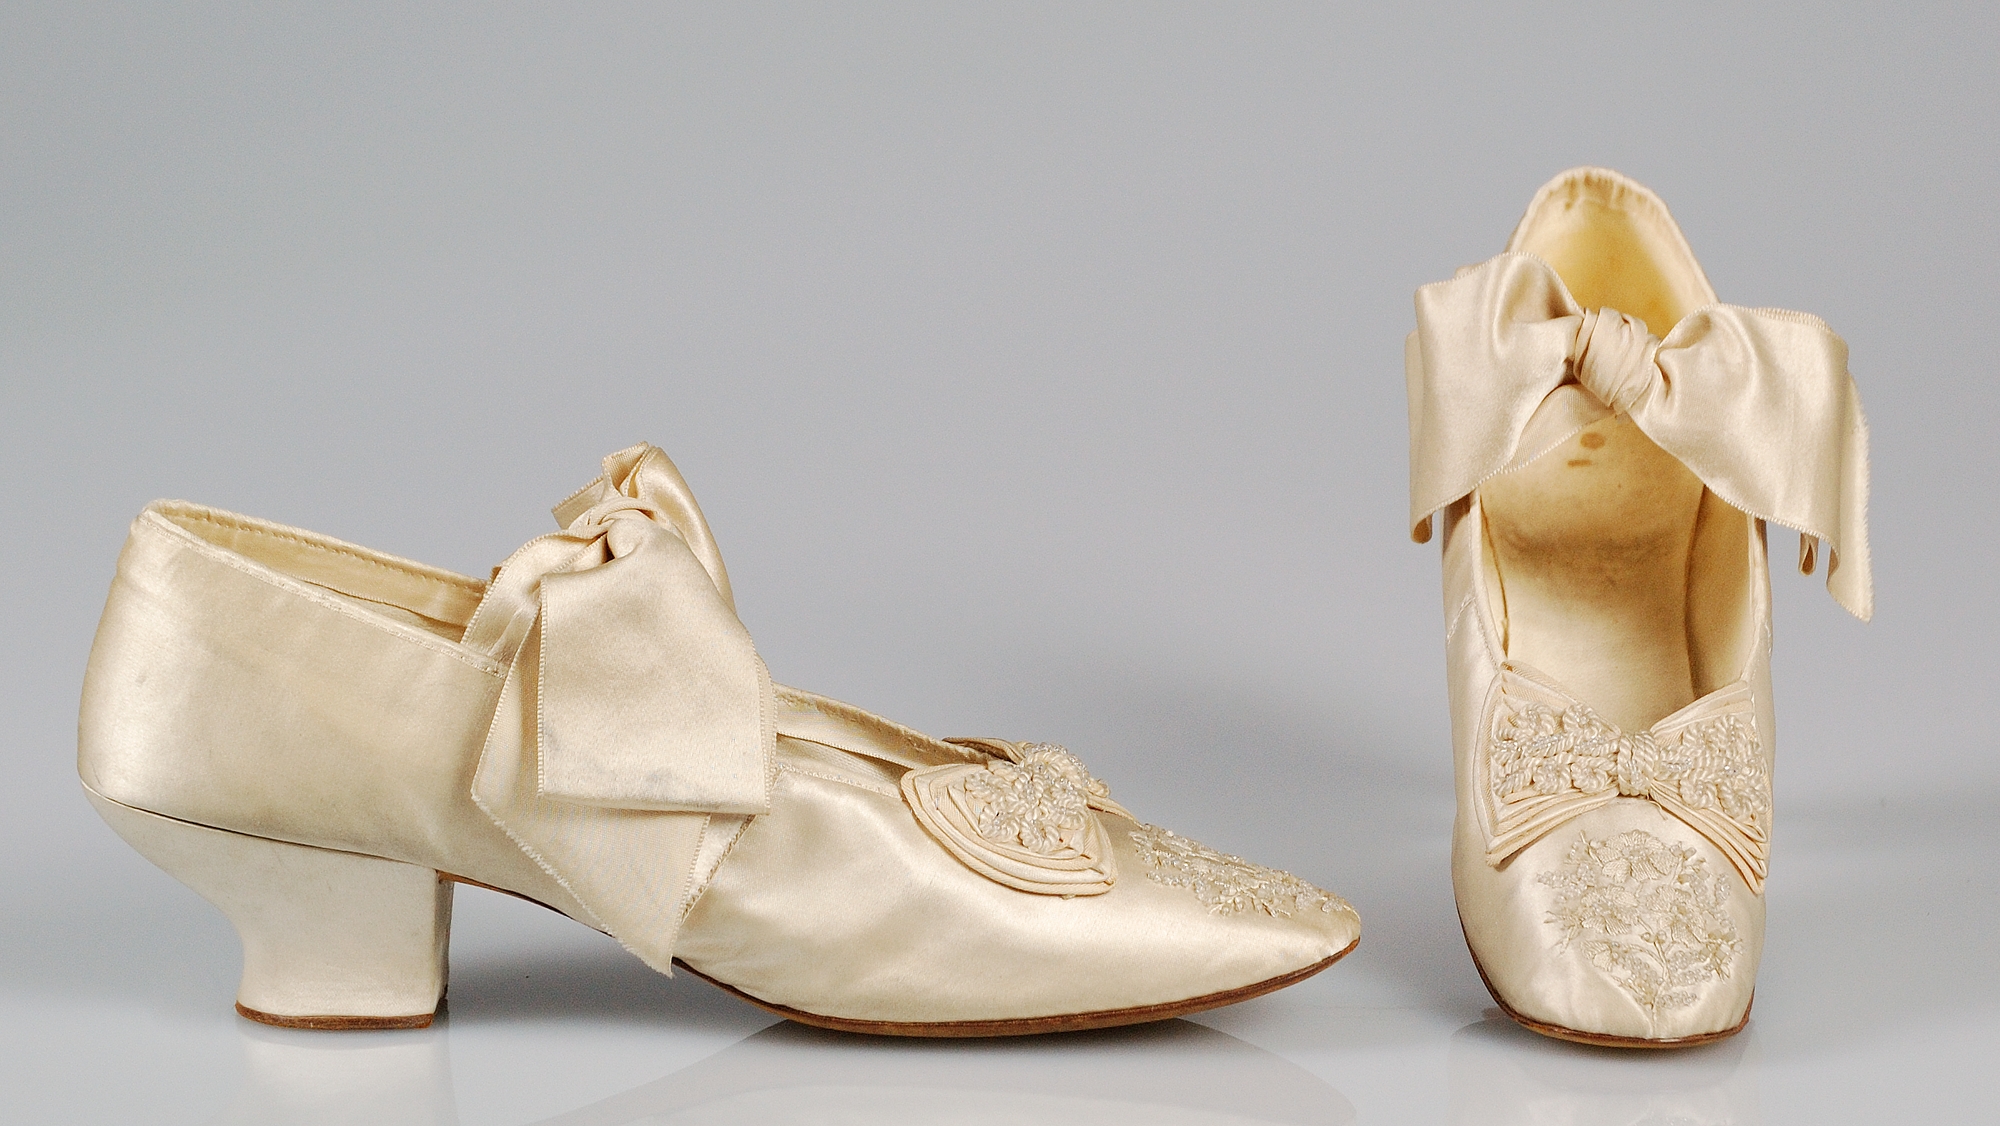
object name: evening shoe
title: Evening shoes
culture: french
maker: g.l. & company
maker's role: maker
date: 1885-1890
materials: silk